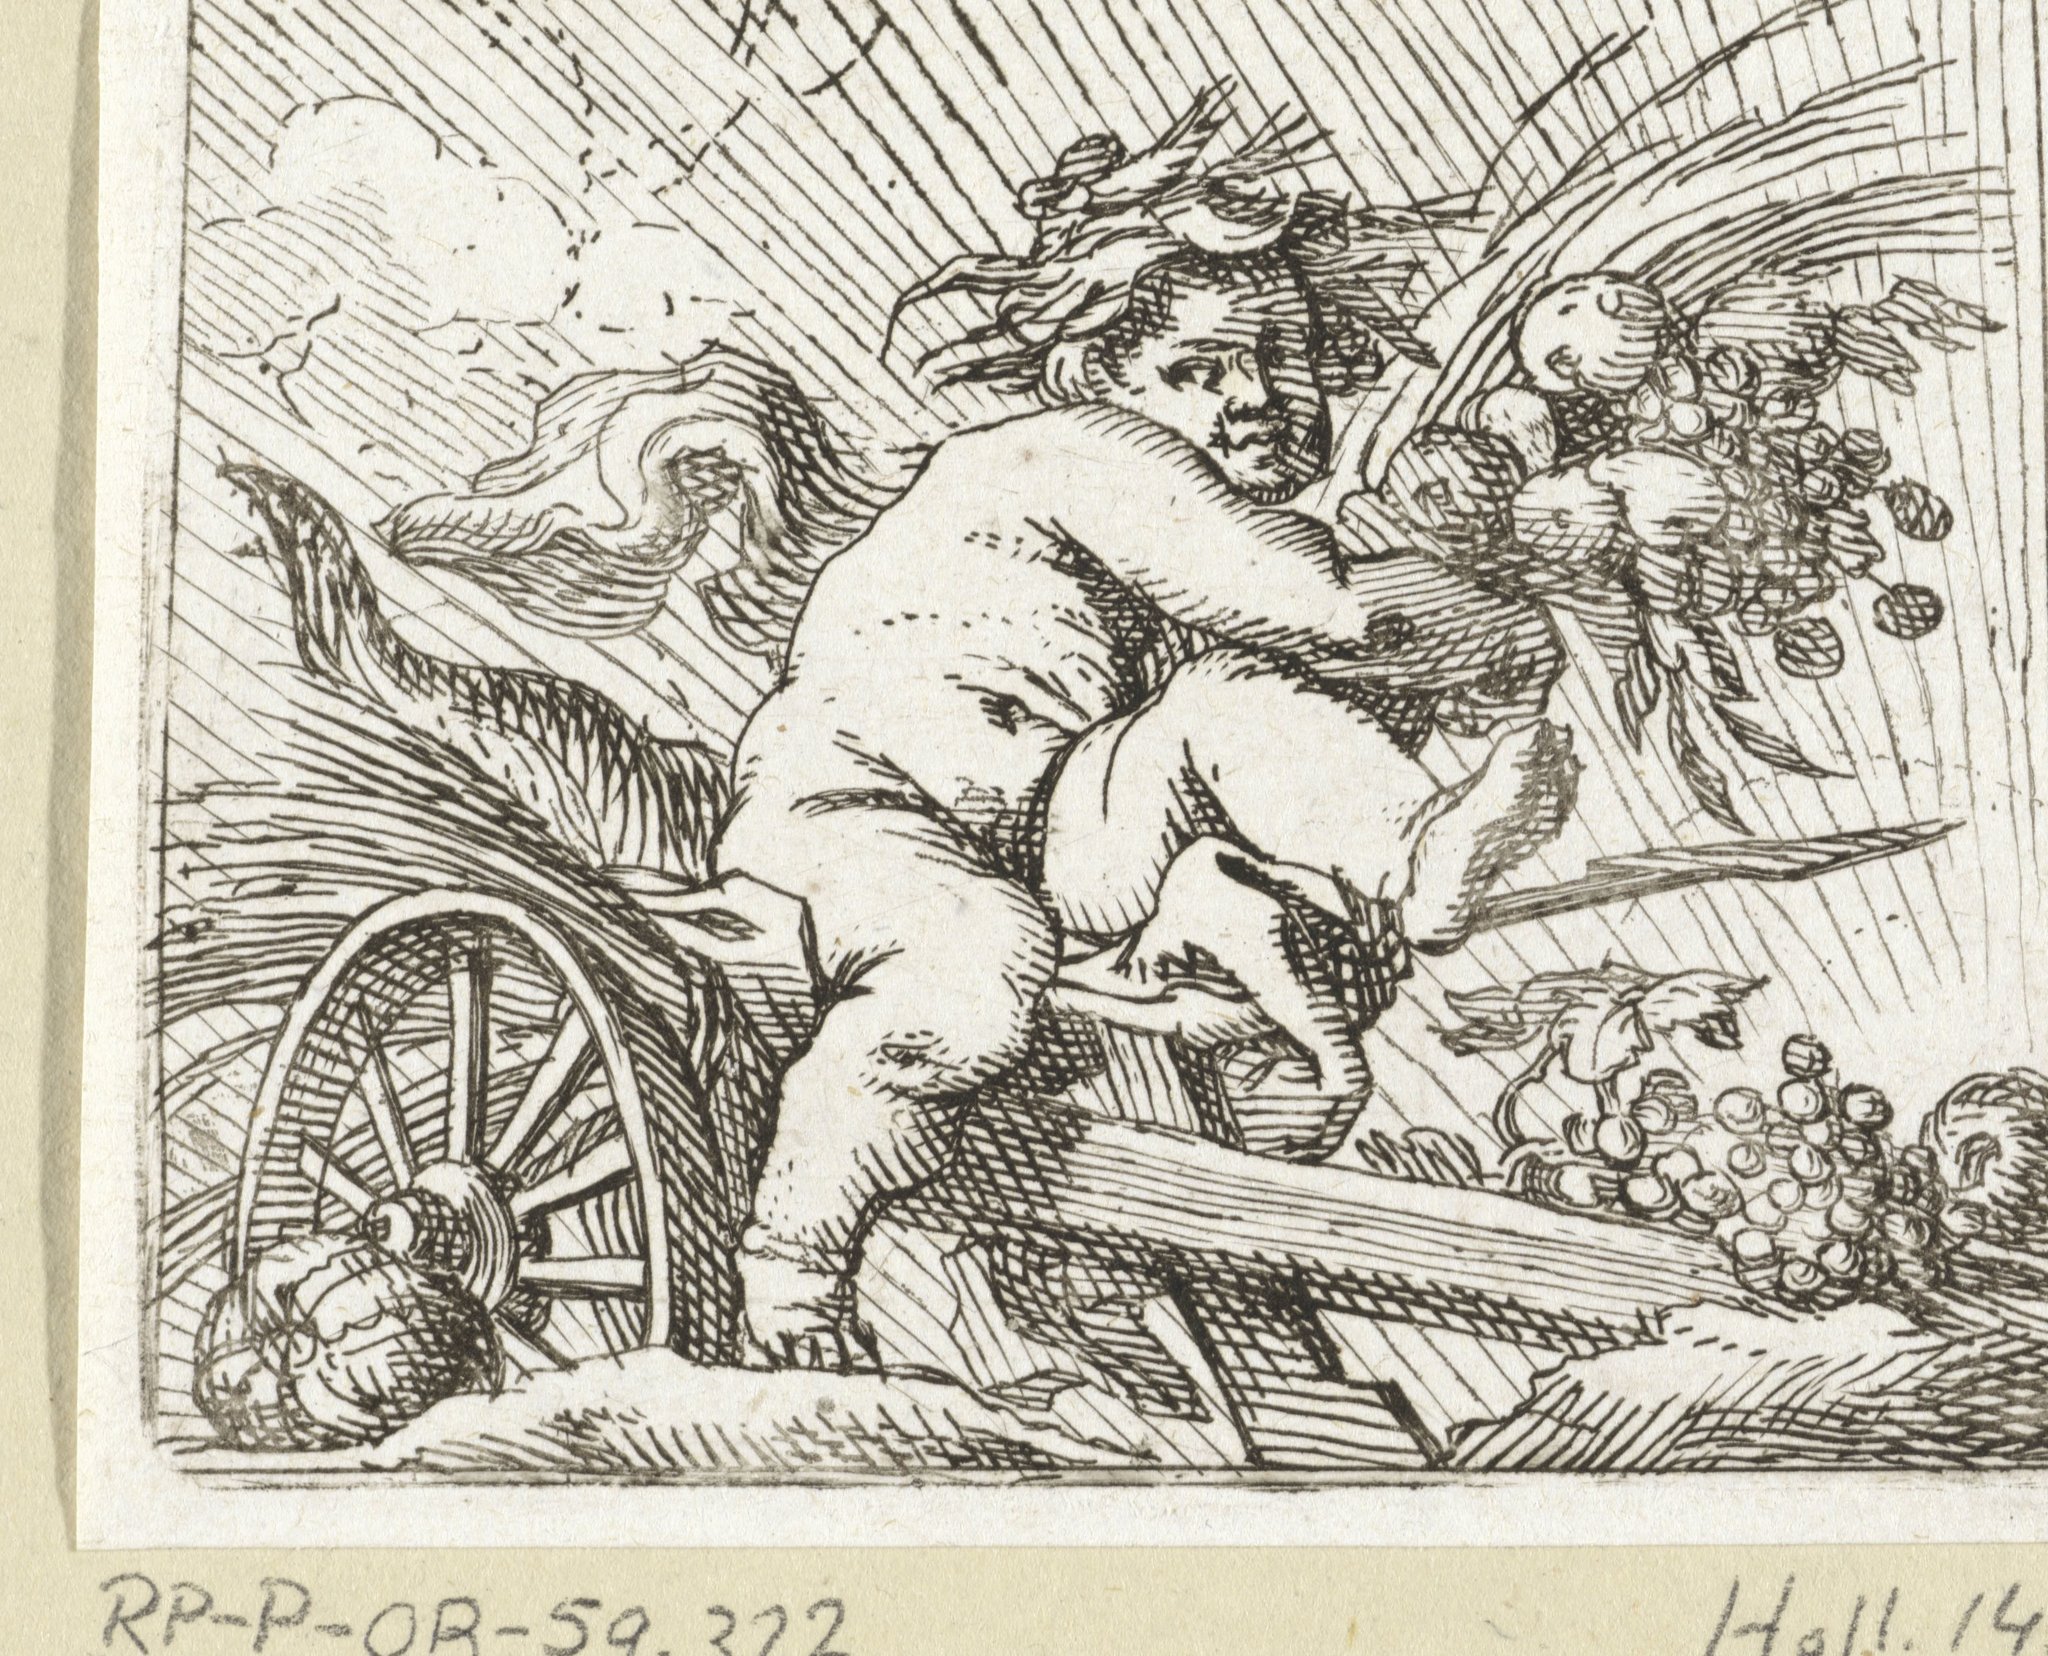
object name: print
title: De vier elementen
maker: cornelis schut (i)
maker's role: draughtsman, print maker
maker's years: 1597-1655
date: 1618-1655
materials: paper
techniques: engraving, etching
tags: air (one of the four elements), agricultural implements: plough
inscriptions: collector's mark: Lugt 240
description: Een kind met zijn armen vol graanhalmen en fruit rijdt op een ploeg door de wolken.